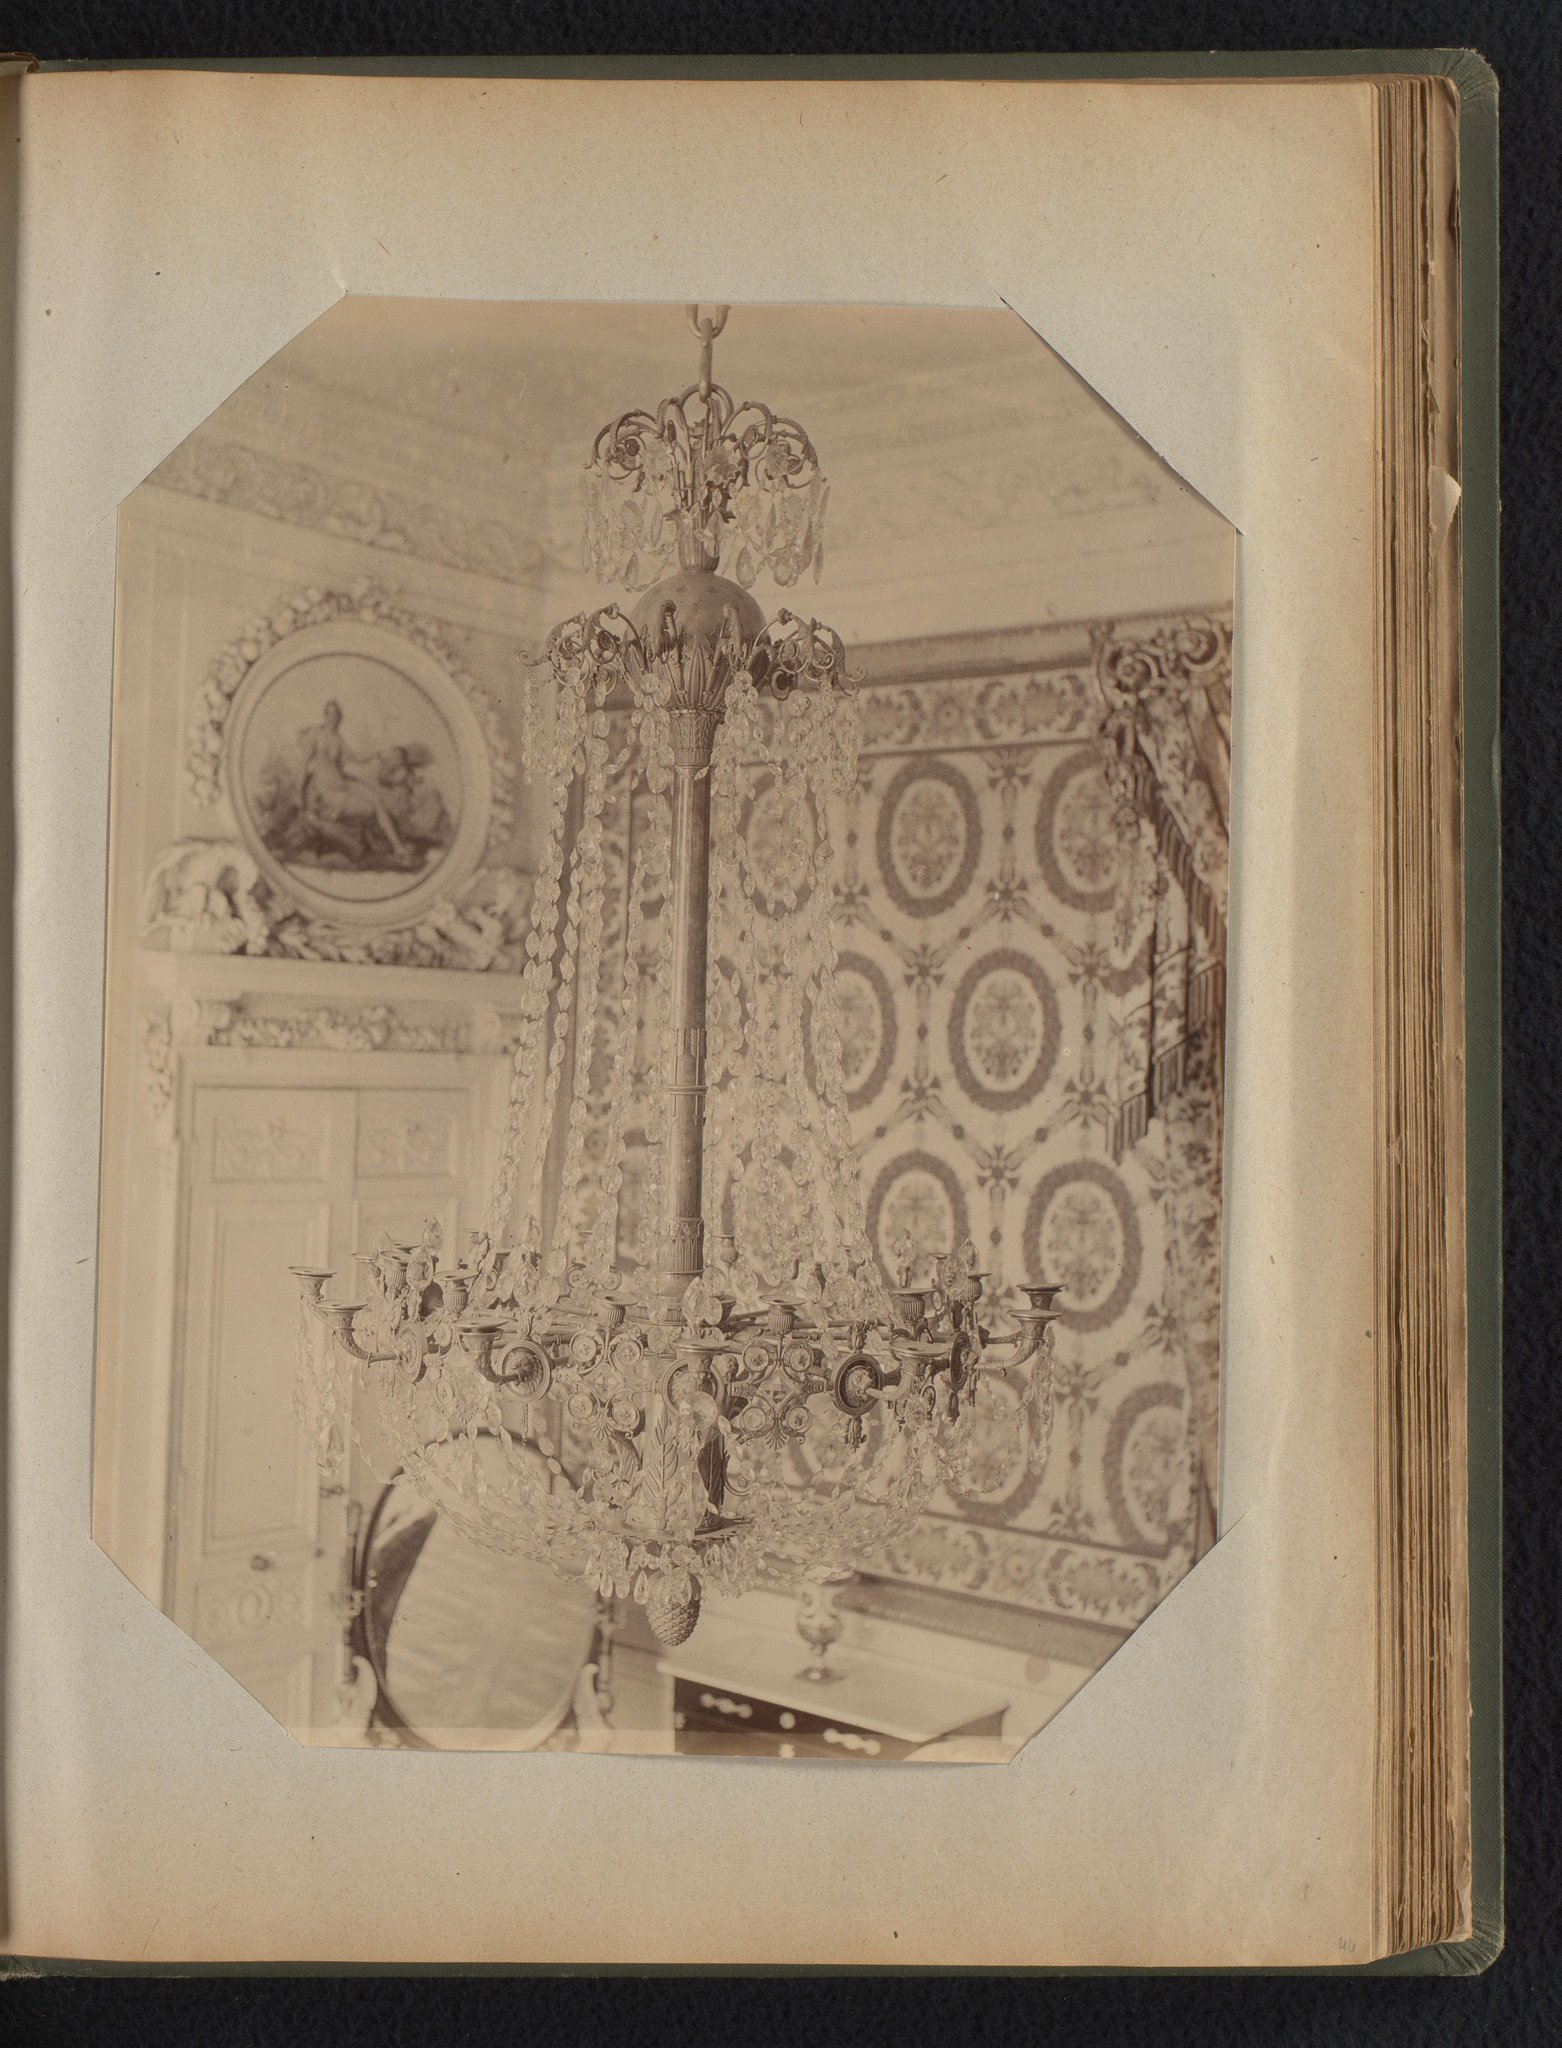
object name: photograph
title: Bronzen kroonluchter met leeuwenkoppen die de kandelaars vasthouden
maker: Anonymous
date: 1860-1900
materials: paper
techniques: albumen print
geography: netherlands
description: Onderdeel van een serie met betrekking tot het interieur van het paleis van Versailles met kroonluchters, deuren, portalen en meubelstukken.